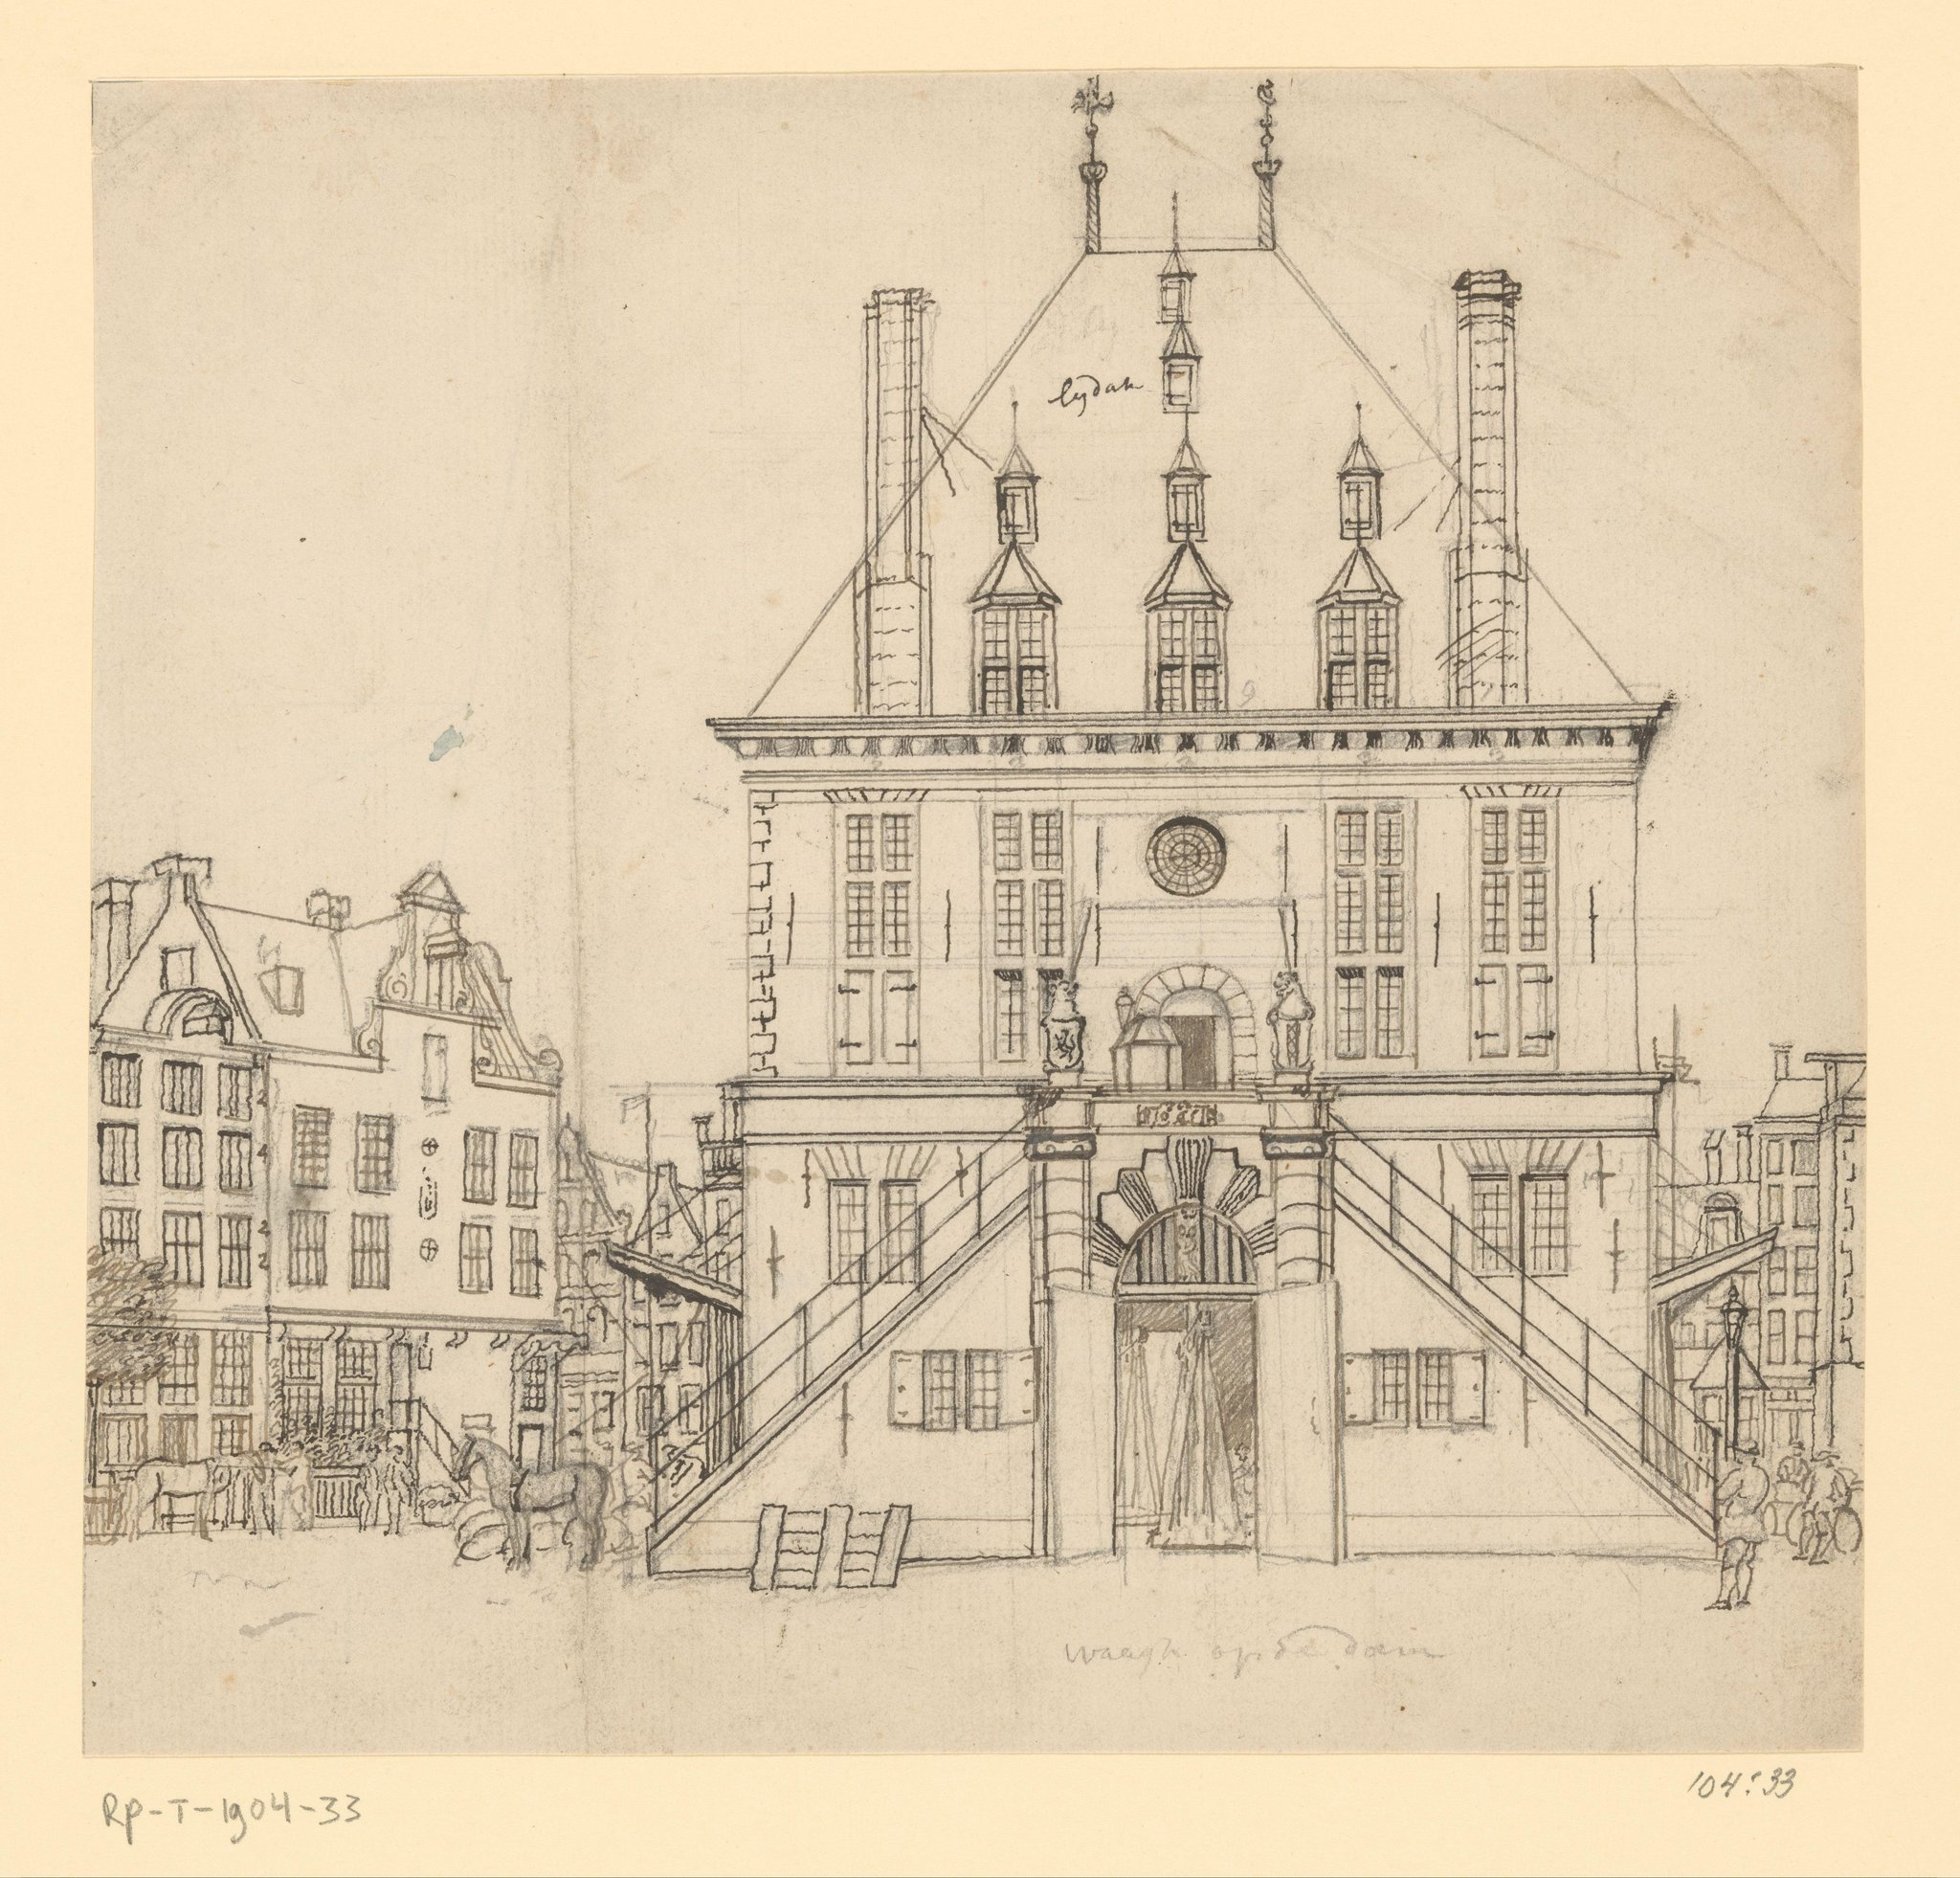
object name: drawing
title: Gezicht op de Waag op de Dam te Amsterdam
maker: Anonymous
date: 1750-1800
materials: ink, paper, pencil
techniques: pen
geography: amsterdam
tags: weigh-house, square, place, circus, etc. (+ city(-scape) with figures, staffage)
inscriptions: collector's mark: Lugt 2166, inscription: ‘waagh op de dam’